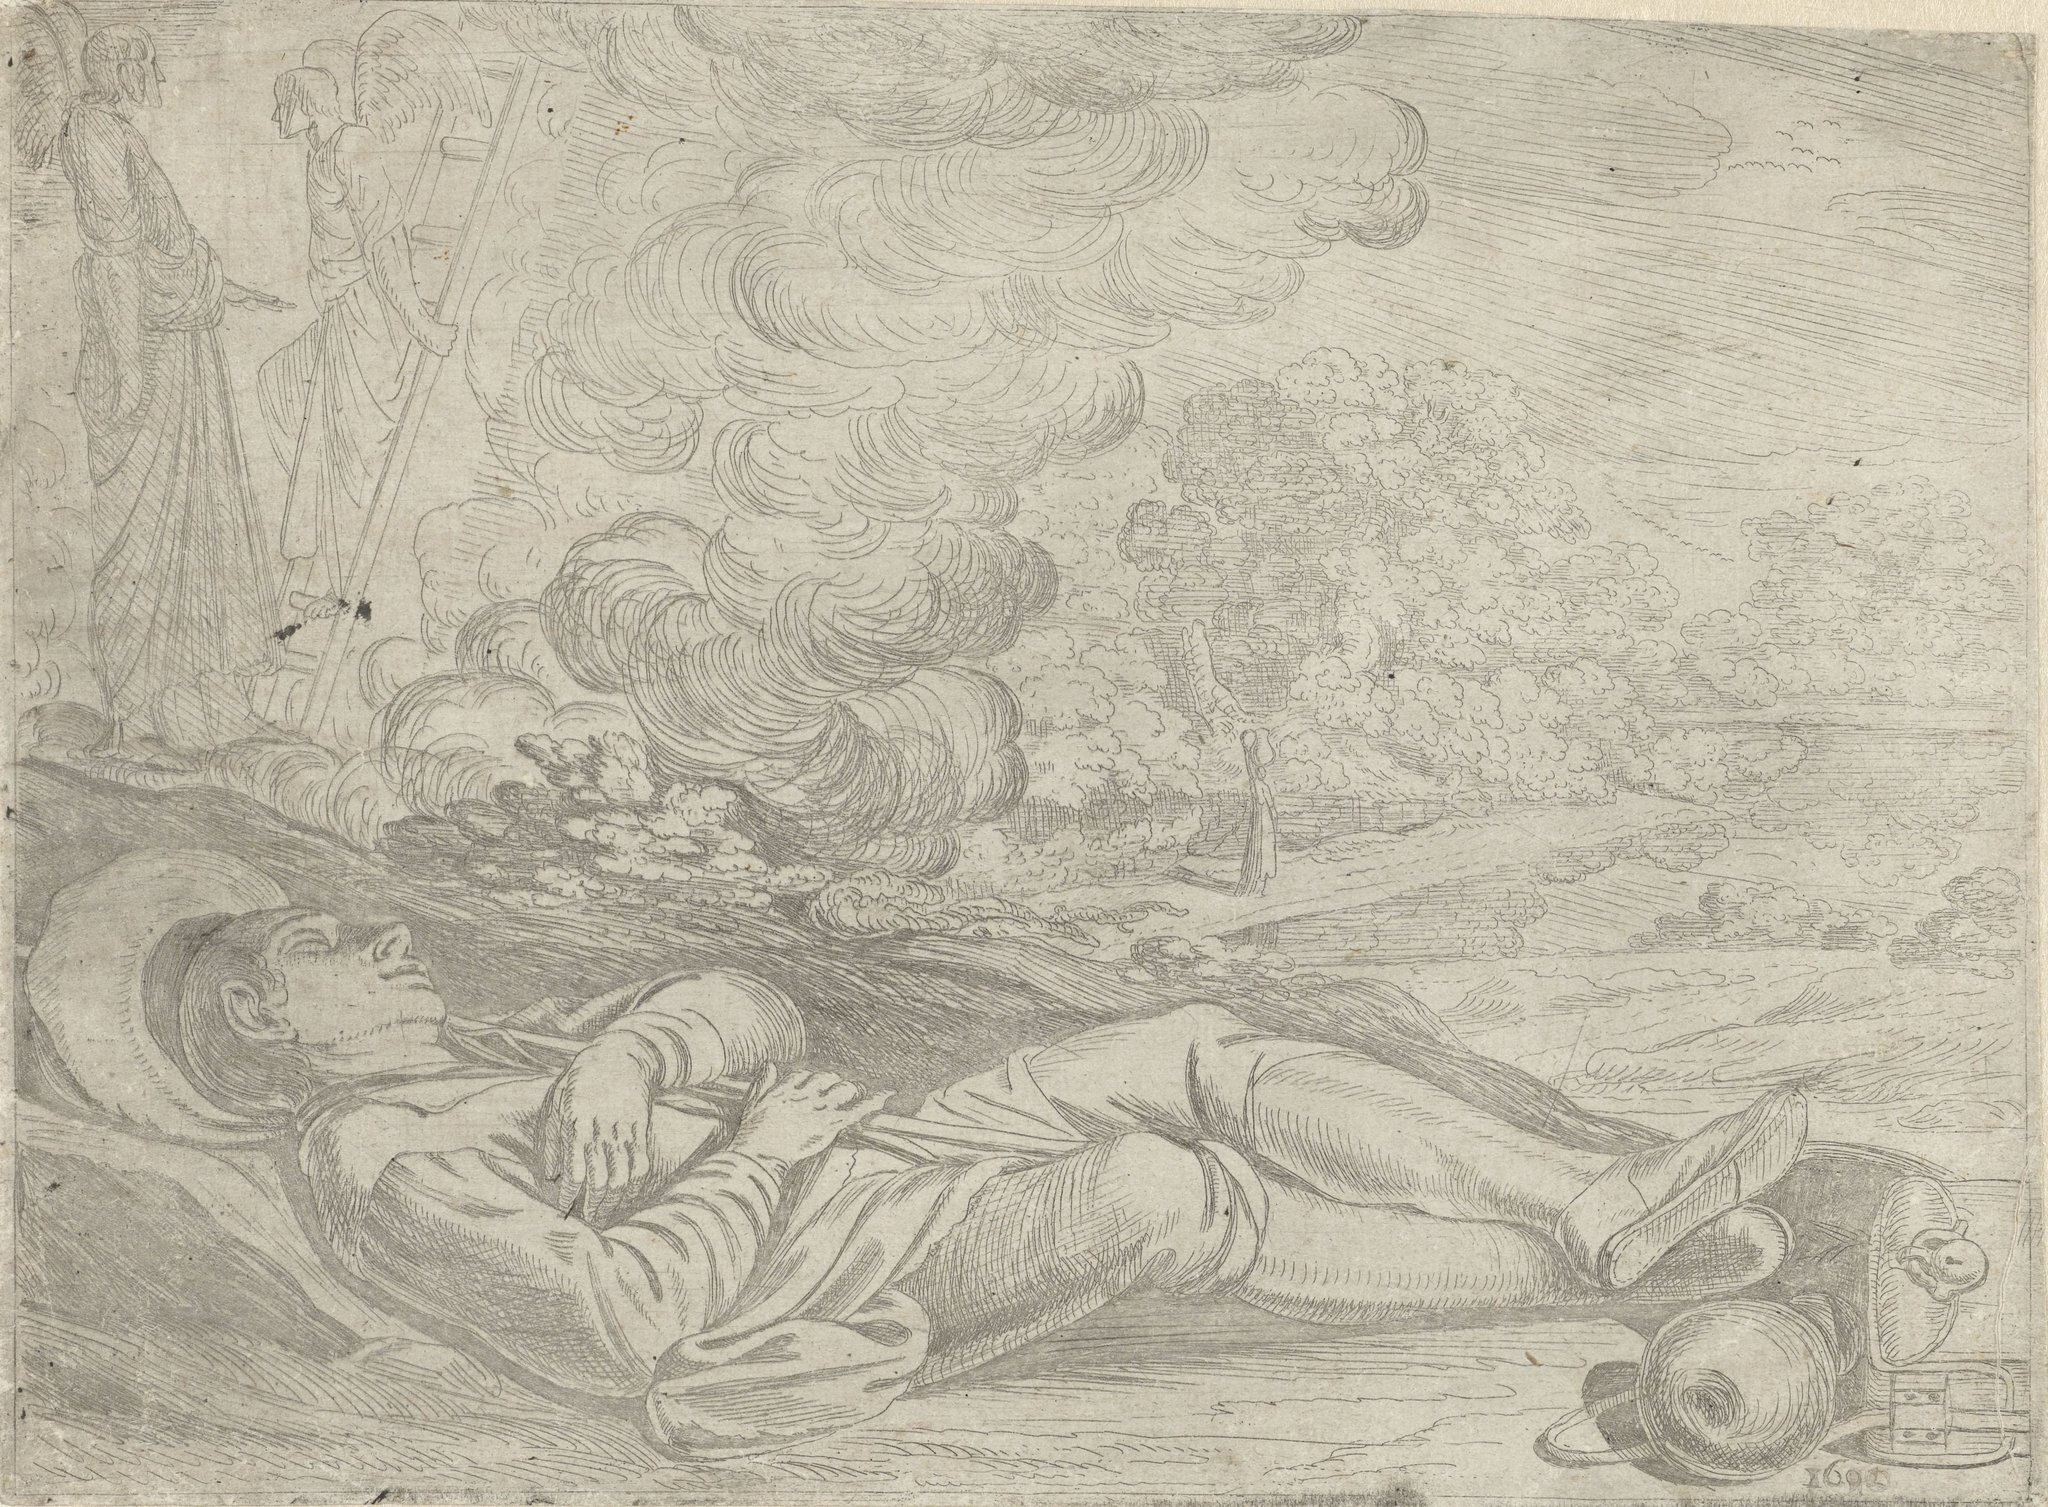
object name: print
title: De droom van Jakob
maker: jan symonsz pynas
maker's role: draughtsman, painter, print maker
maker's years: 1581-1631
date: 1601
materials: paper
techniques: etching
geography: amsterdam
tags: the dream of jacob: while sleeping on the ground with a stone for pillow jacob sees a ladder reaching from earth to heaven with angels going up and down; usually with god at the top of the ladder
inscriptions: collector's mark: Lugt 2228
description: Tijdens zijn reis naar Haran neemt Jakob een steen als hoofdkussen en gaat slapen. Hij droomt over een ladder die tot aan de hemel reikt en waarlangs engelen afdalen.